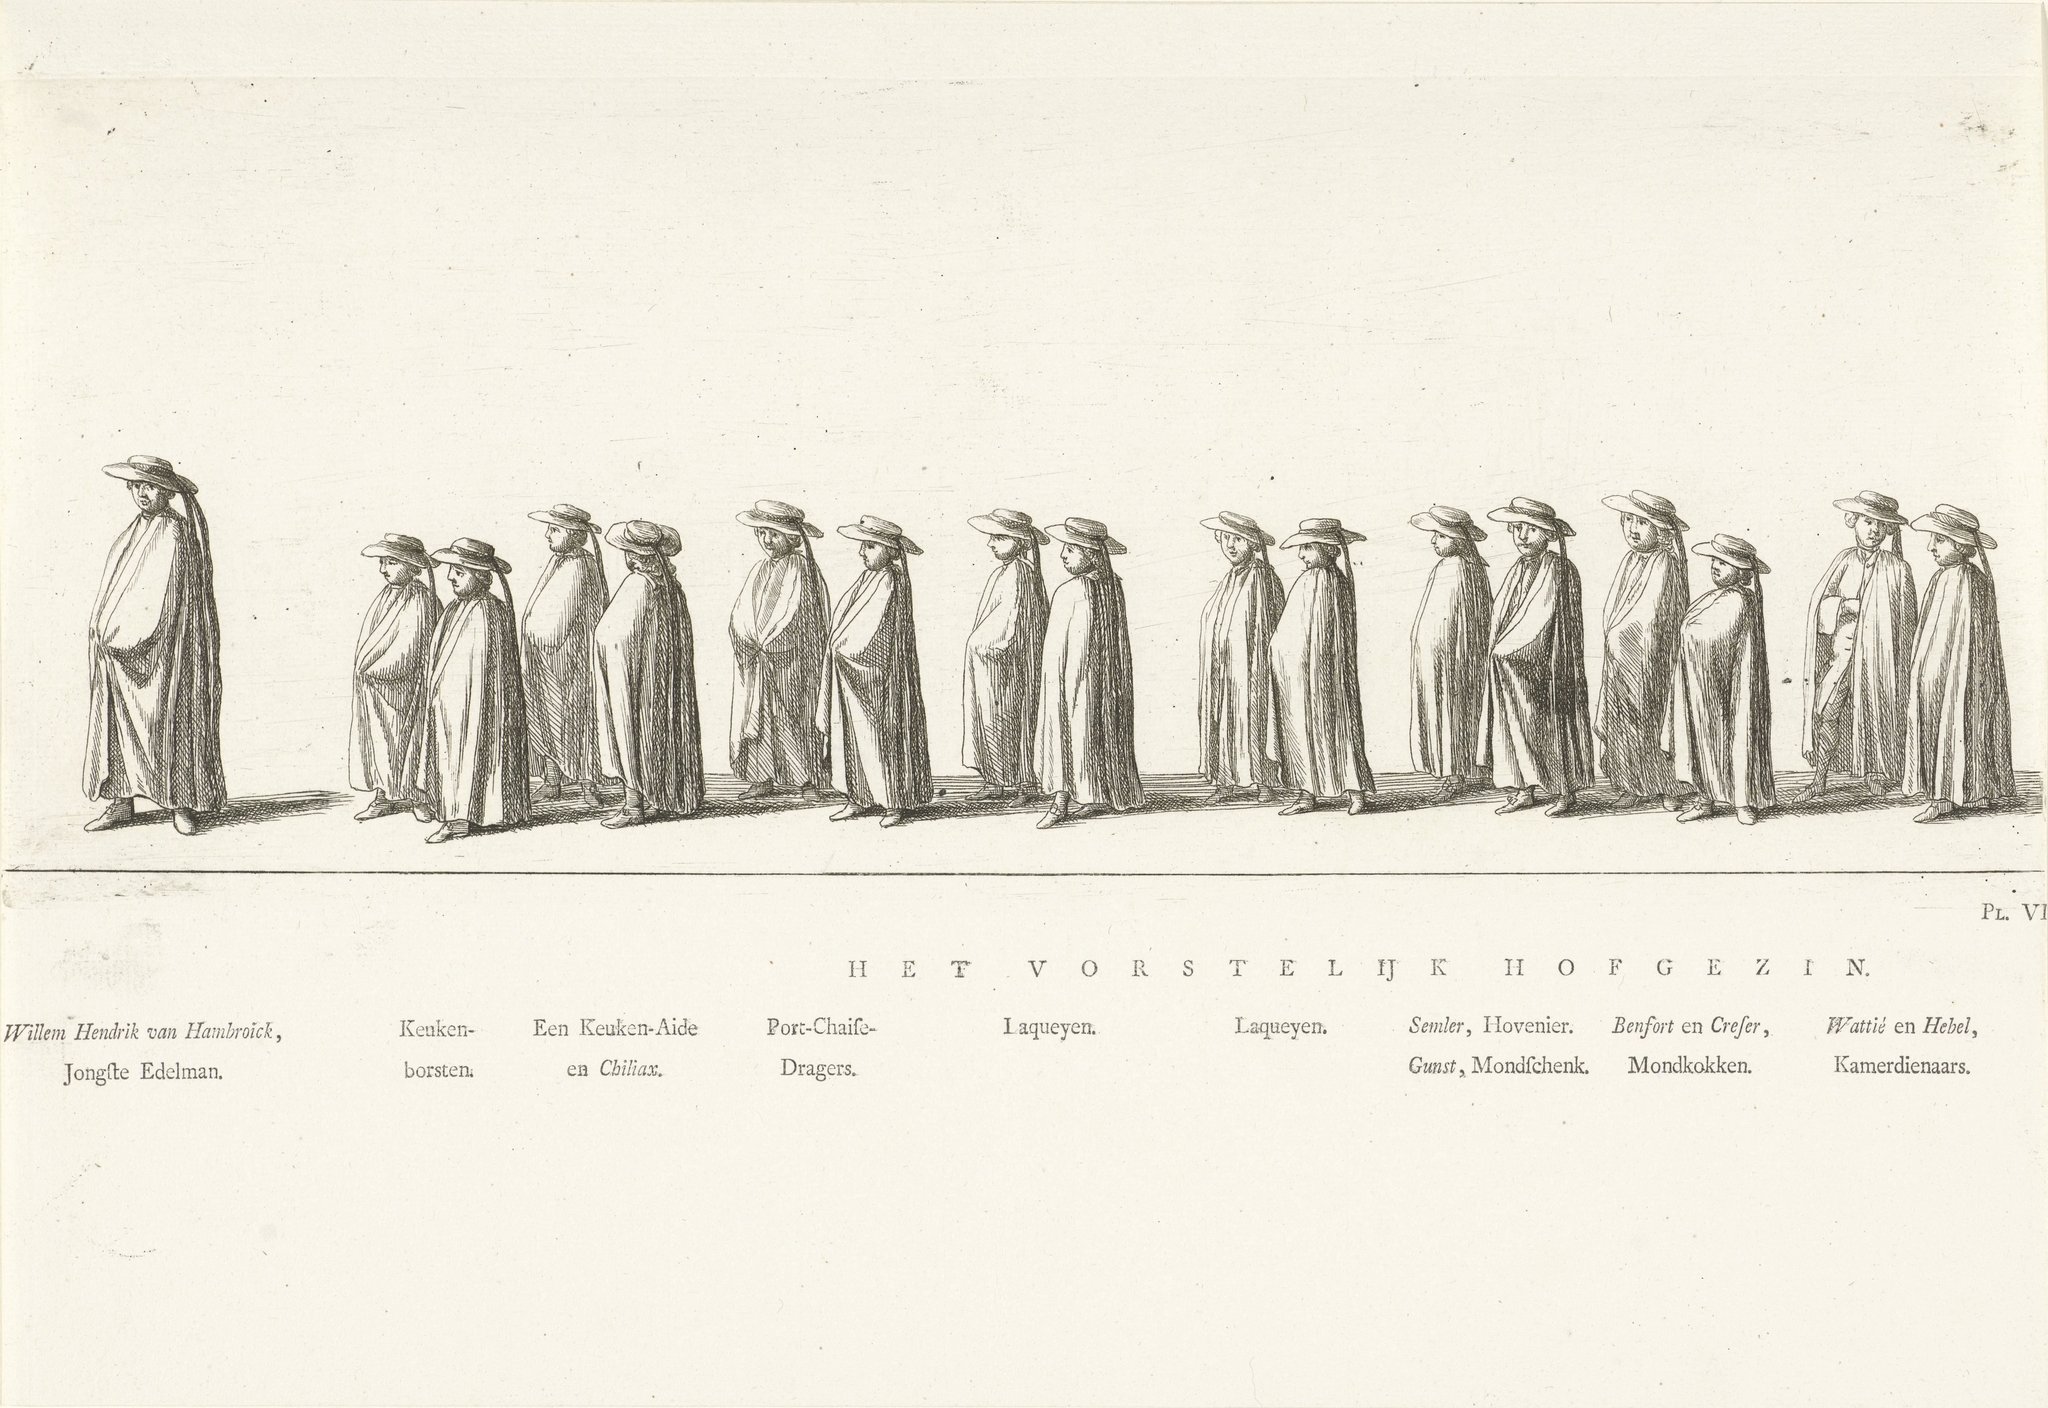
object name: print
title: Lijkstatie van prinses Maria Louise, 1765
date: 1765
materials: paper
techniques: etching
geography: leeuwarden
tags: cortege, funeral procession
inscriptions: collector's mark: Lugt 2228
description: De leden van de stadhouderlijke hofhouding. Gemerkt rechtsonder: Pl. VI. Op het blad onder de plaat de titel en de namen van personen in de stoet. Onderdeel van de serie platen van de begrafenis van prinses Maria Louise te Leeuwarden op 13 juni 1765.